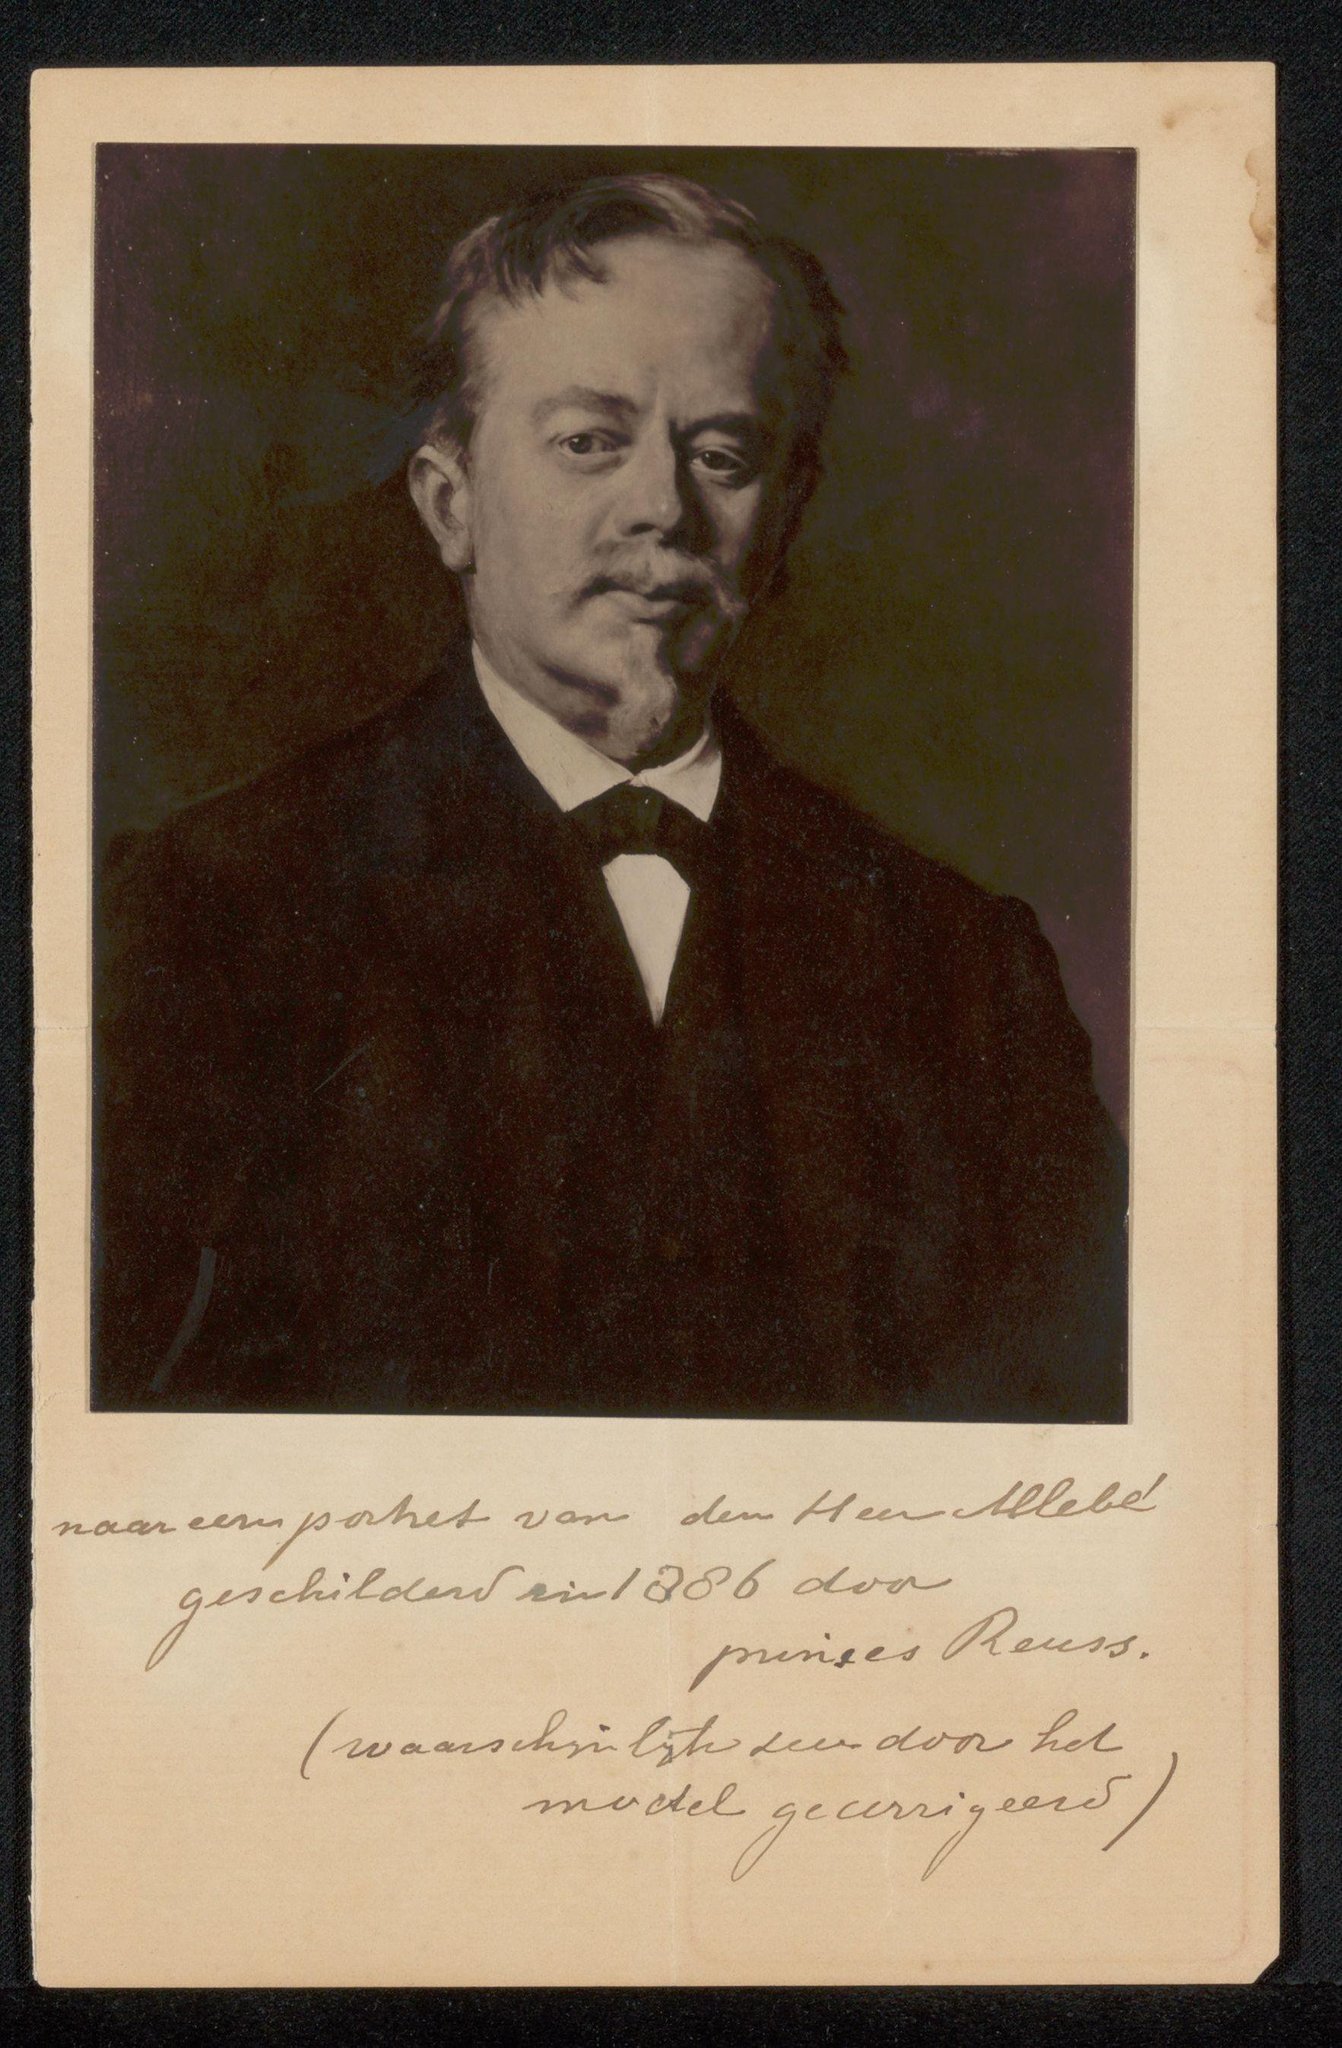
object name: reproduction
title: Fotoreproductie van een geschilderd portret van August Allebé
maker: Anonymous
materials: ink, paper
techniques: carbon print, pen, writing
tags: amsterdam, print maker, draughtsman, august allebé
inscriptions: collector's mark: ‘RPK’